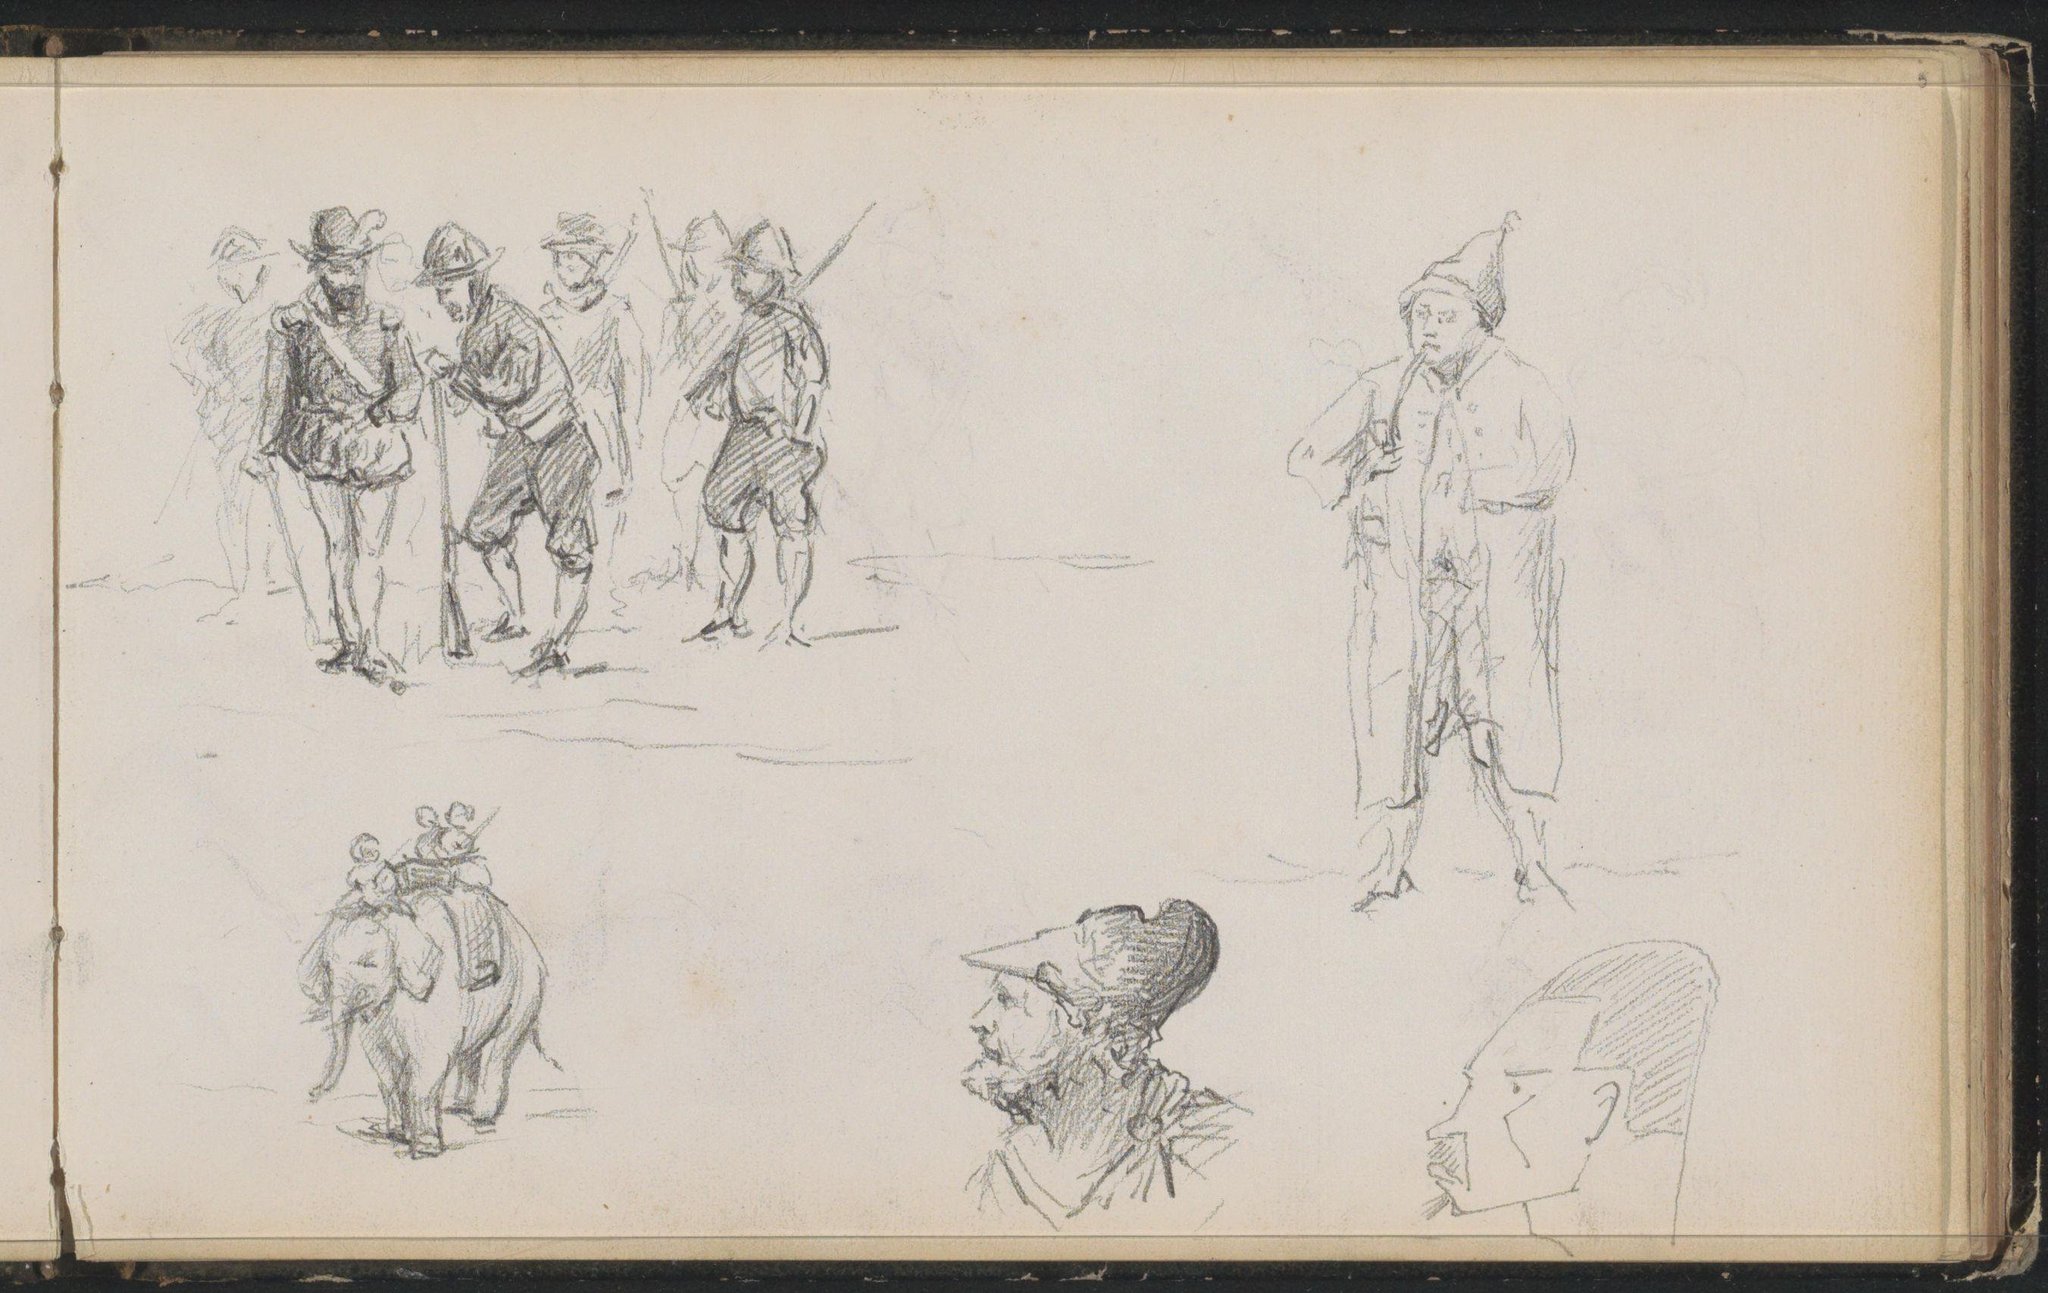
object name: sketchbook leaf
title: Studieblad, onder andere met militairen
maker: marius bauer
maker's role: draughtsman, print maker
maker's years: 1867-1932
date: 1812-1880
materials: paper, pencil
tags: helmet, head (human), pipe ~ tobacco, (military) uniforms, trunked animals: elephant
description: Tevens studies van figuren op een olifant, een militair, een mannenkop en een figuur met puntmuts en pijp. Pagina 9 uit een schetsboek met 34 bladen.